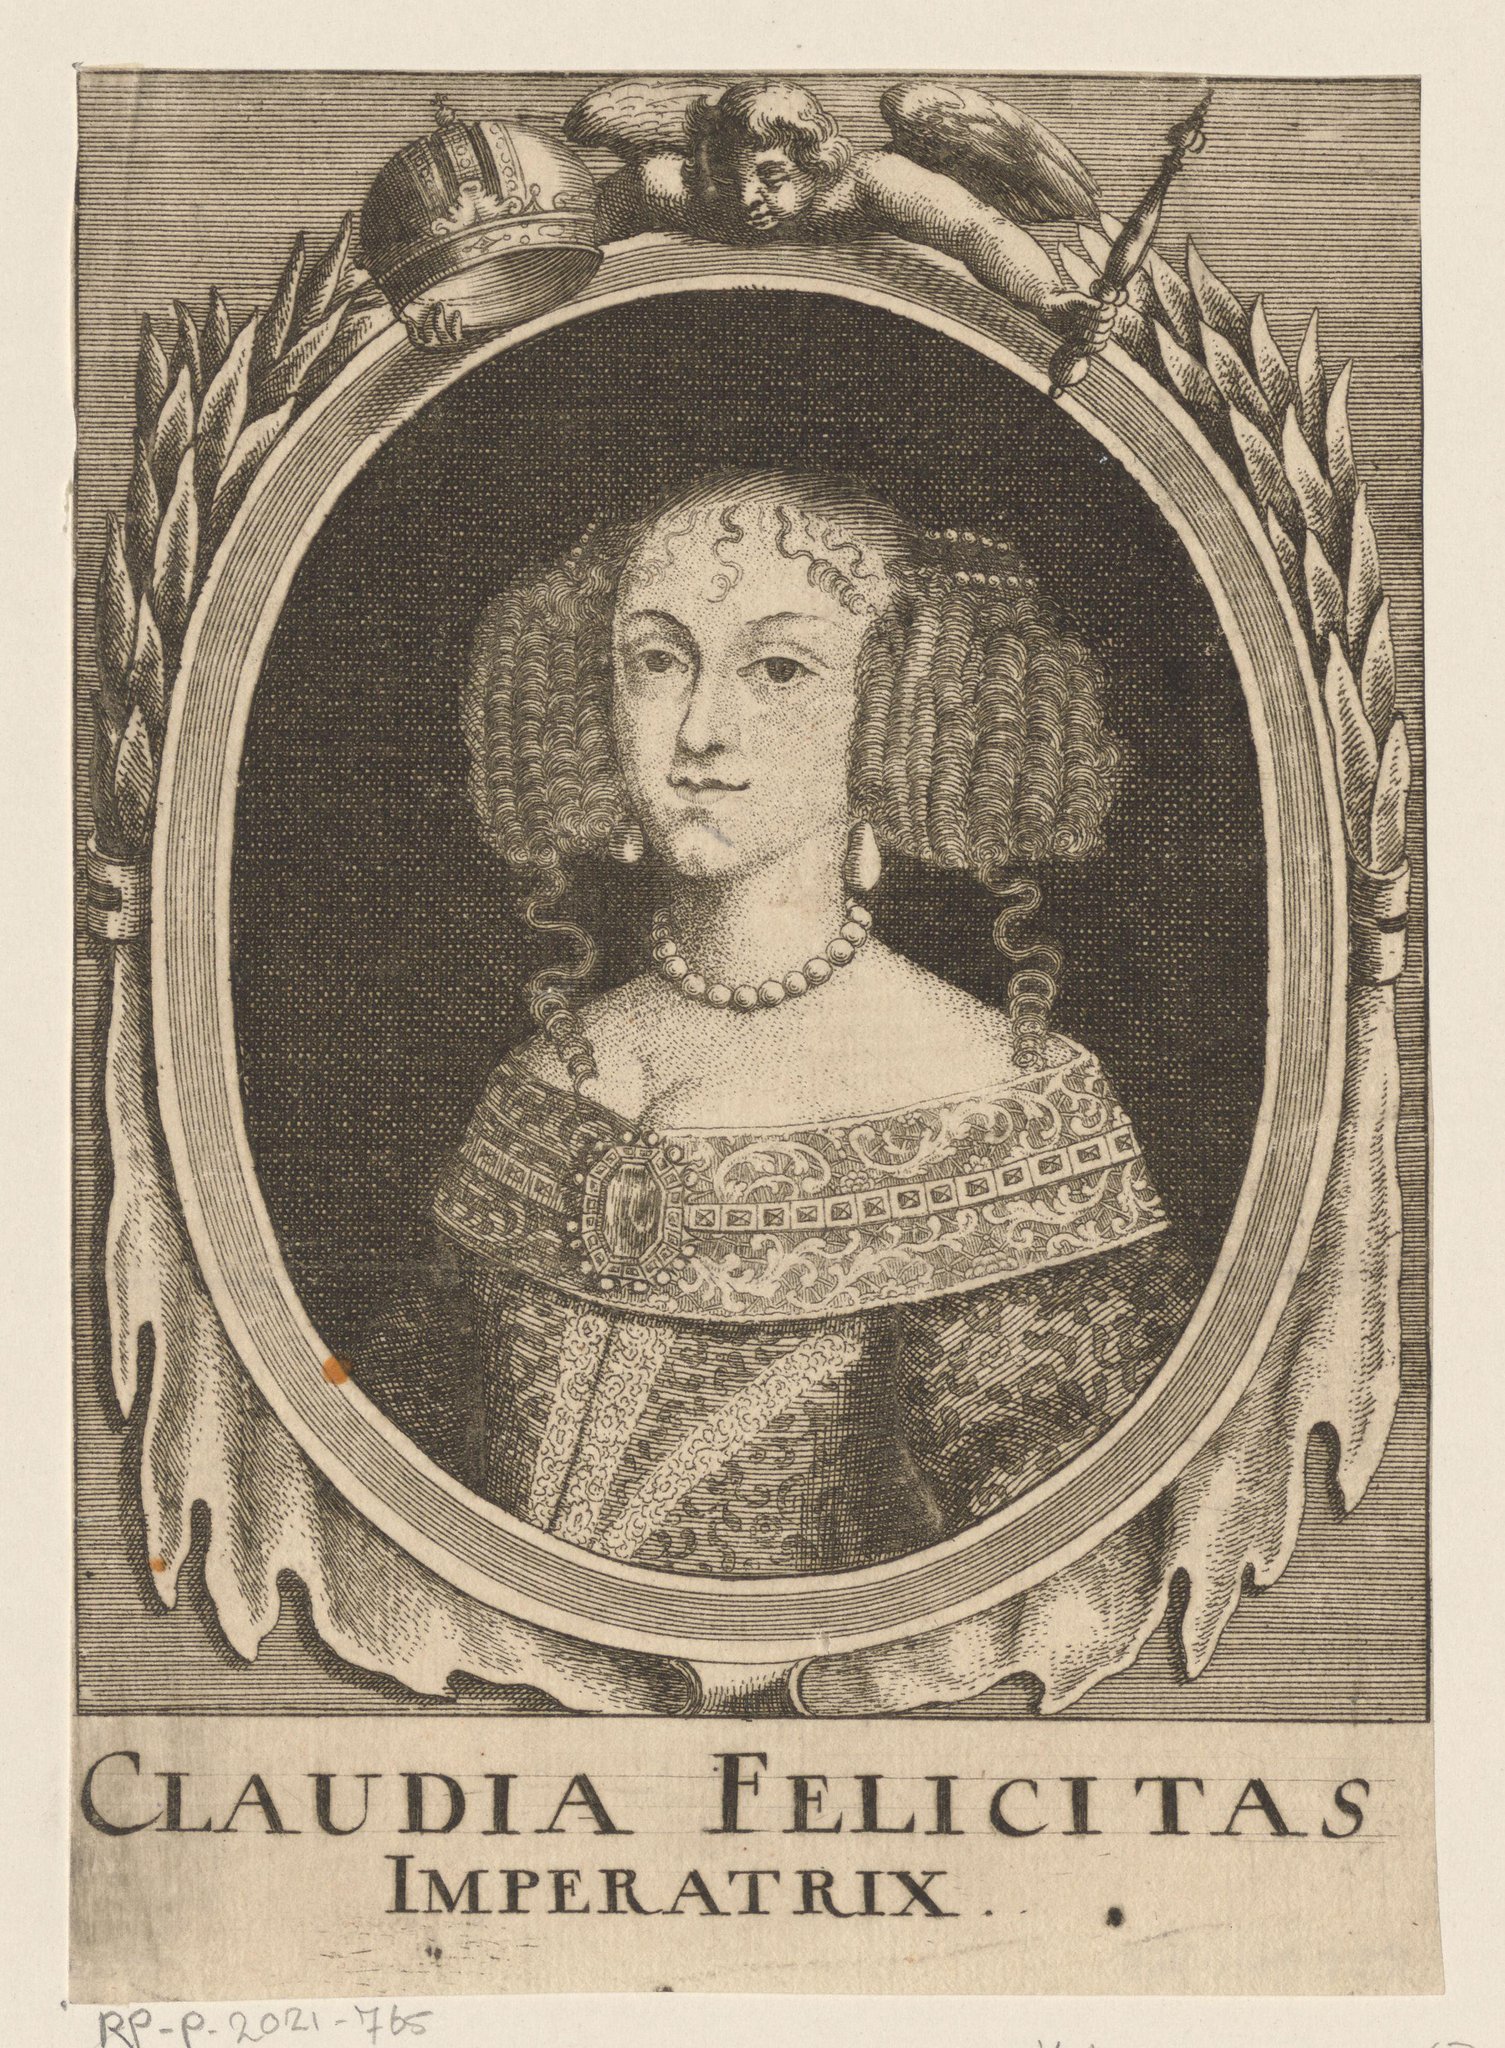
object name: print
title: Portret van Claudia Felicitas, hertogin van Oostenrijk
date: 1673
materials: paper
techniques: engraving, etching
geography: nuremberg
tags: crown (symbol of sovereignty), sceptre, staff (symbol of sovereignty), historical persons, cupids: 'amores', 'amoretti', 'putti'